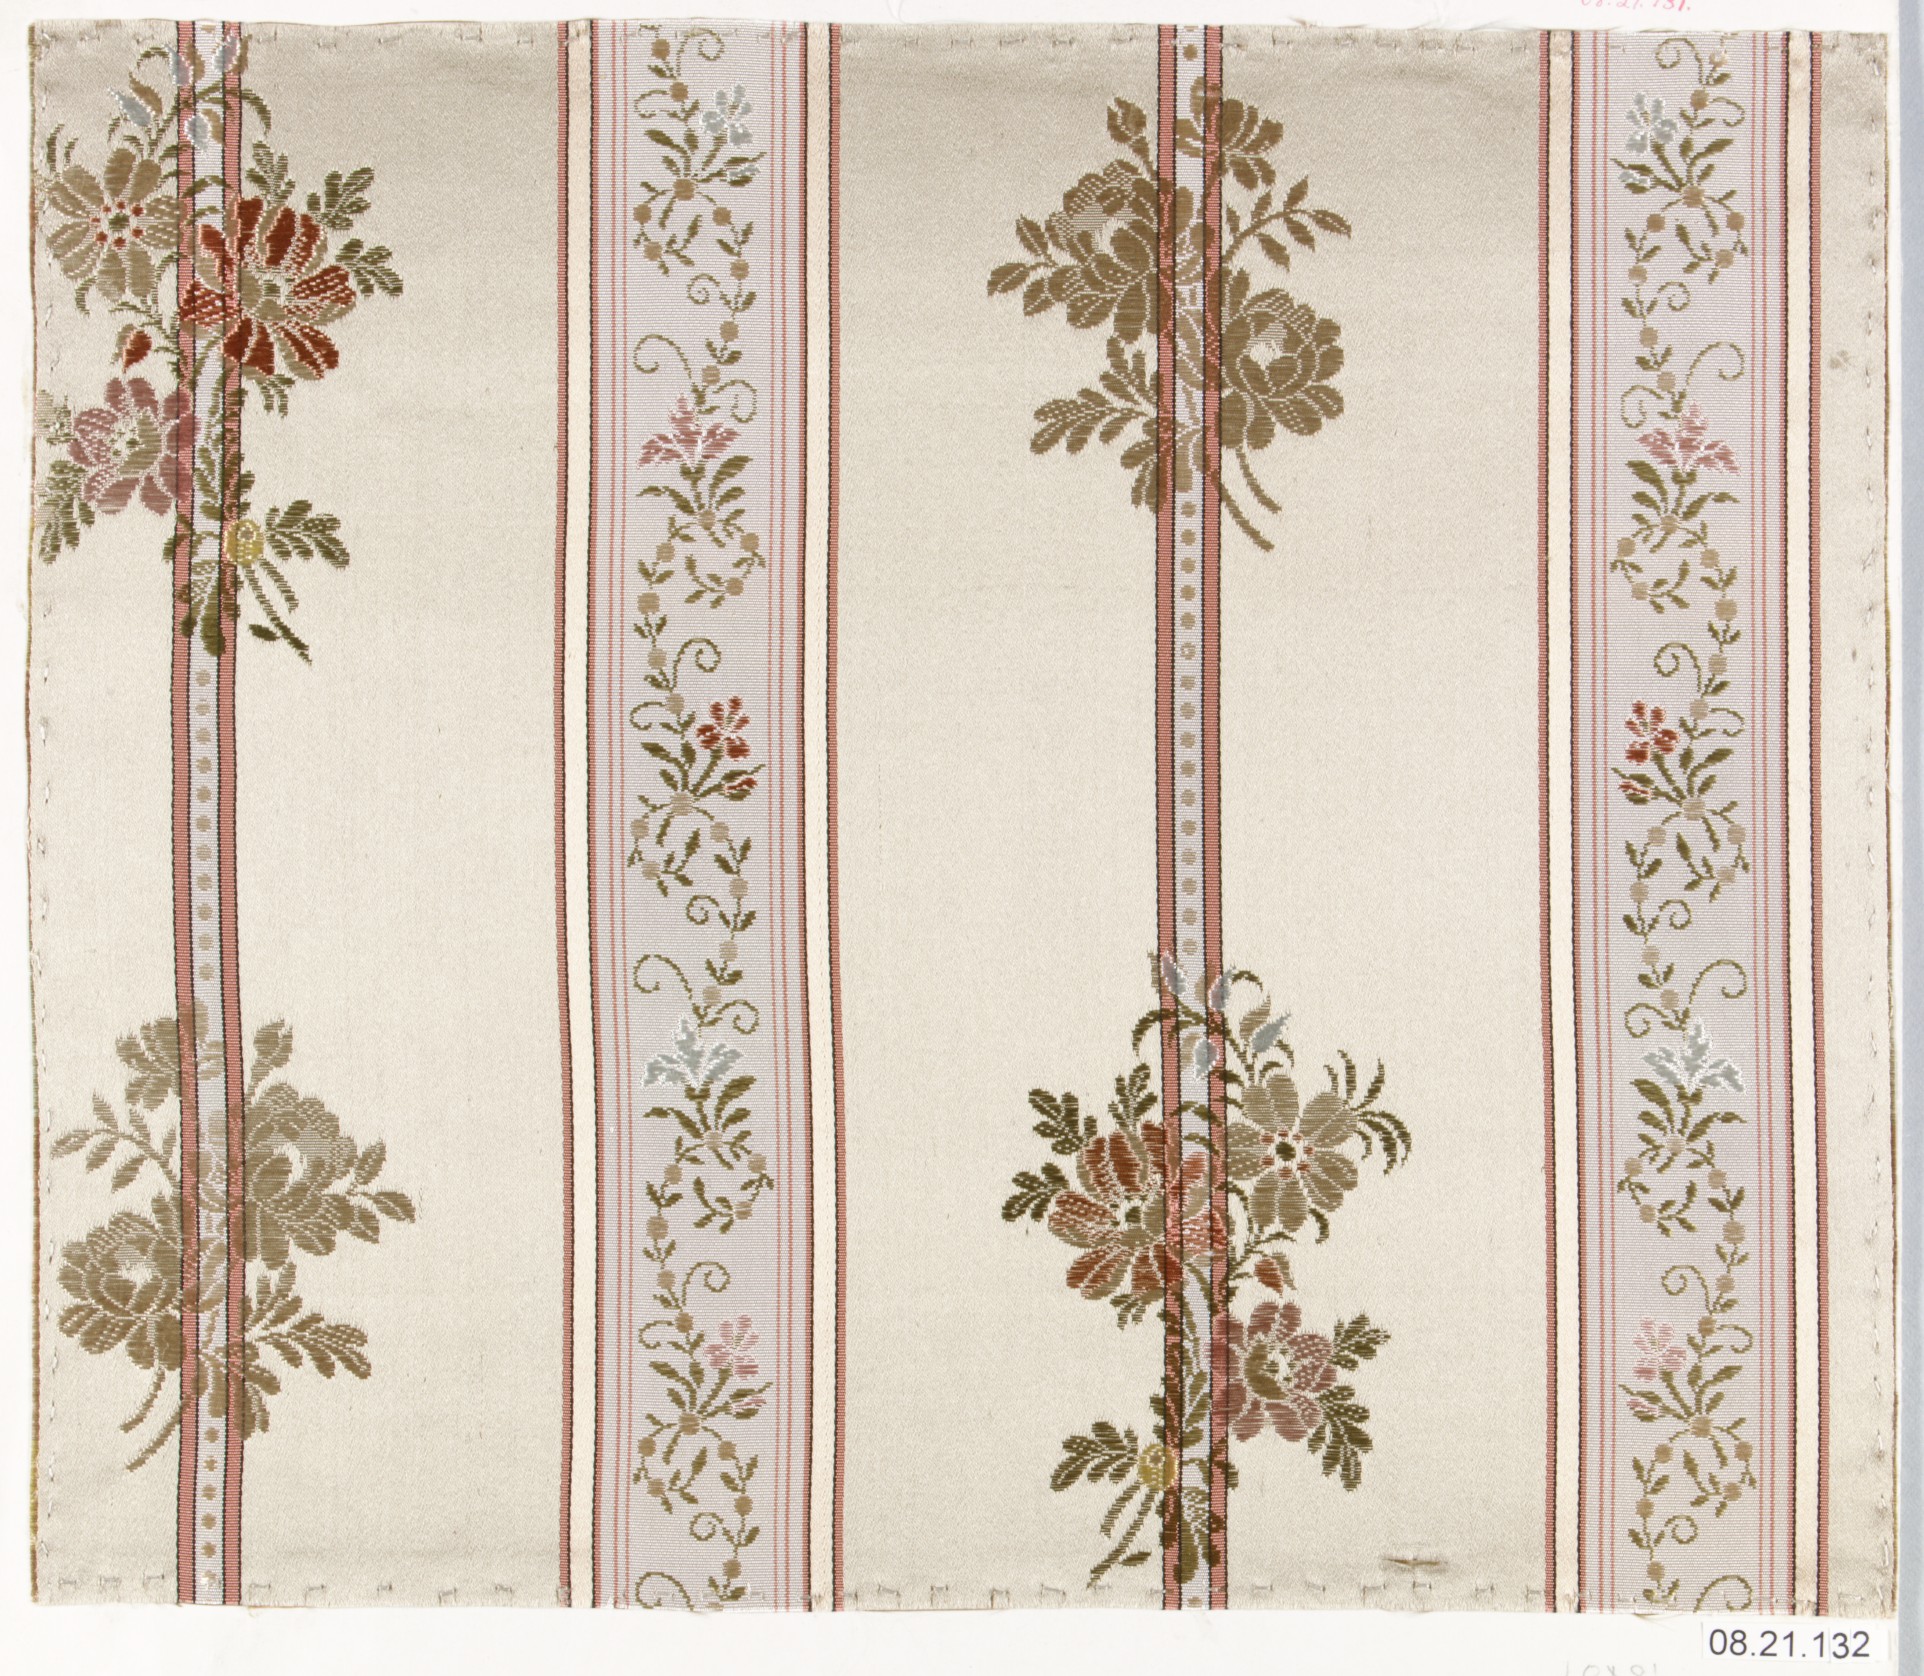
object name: textile sample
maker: Anonymous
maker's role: designer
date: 1900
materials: silk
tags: flowers